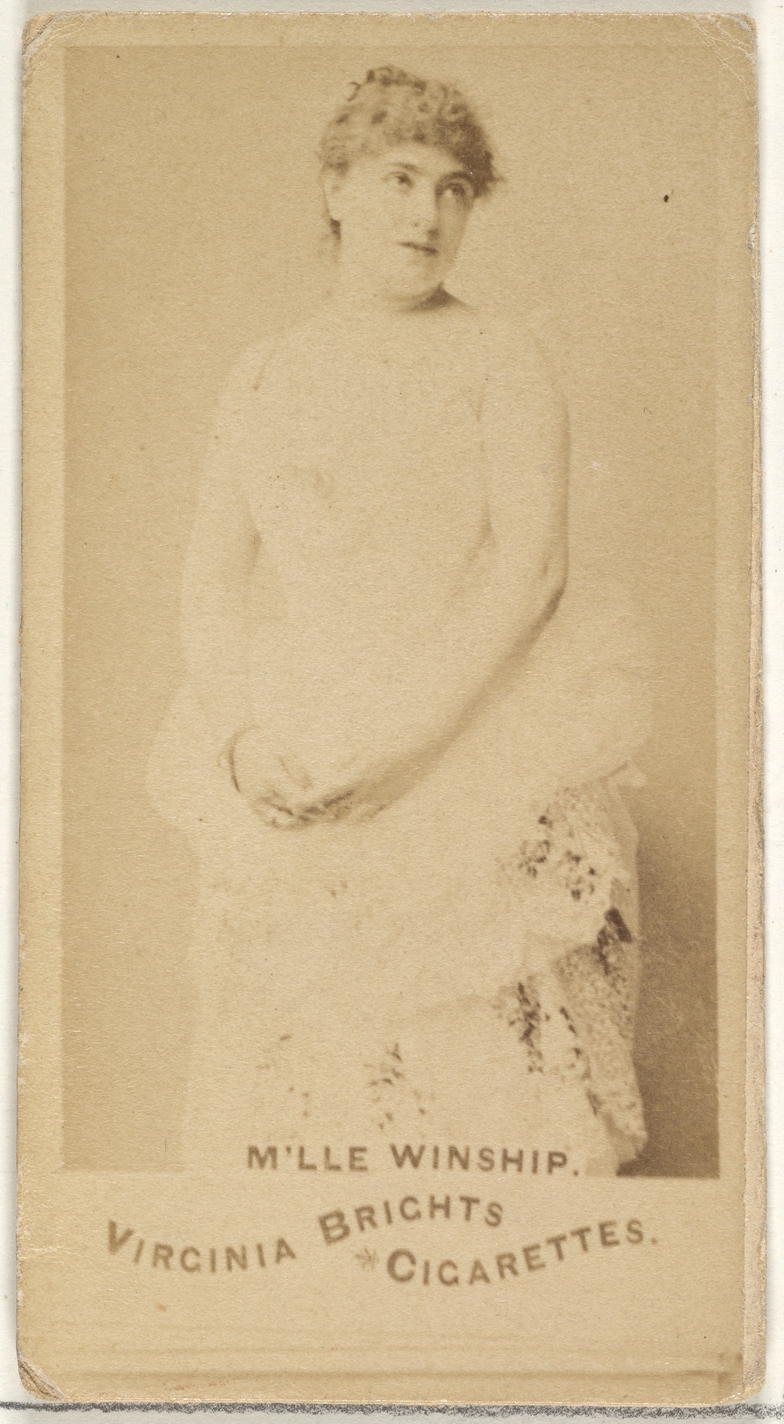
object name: photograph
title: M'lle Winship, from the Actors and Actresses series (N45, Type 1) for Virginia Brights Cigarettes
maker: allen & ginter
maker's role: publisher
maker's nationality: american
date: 1888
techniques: albumen silver print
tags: portraits,women,actresses